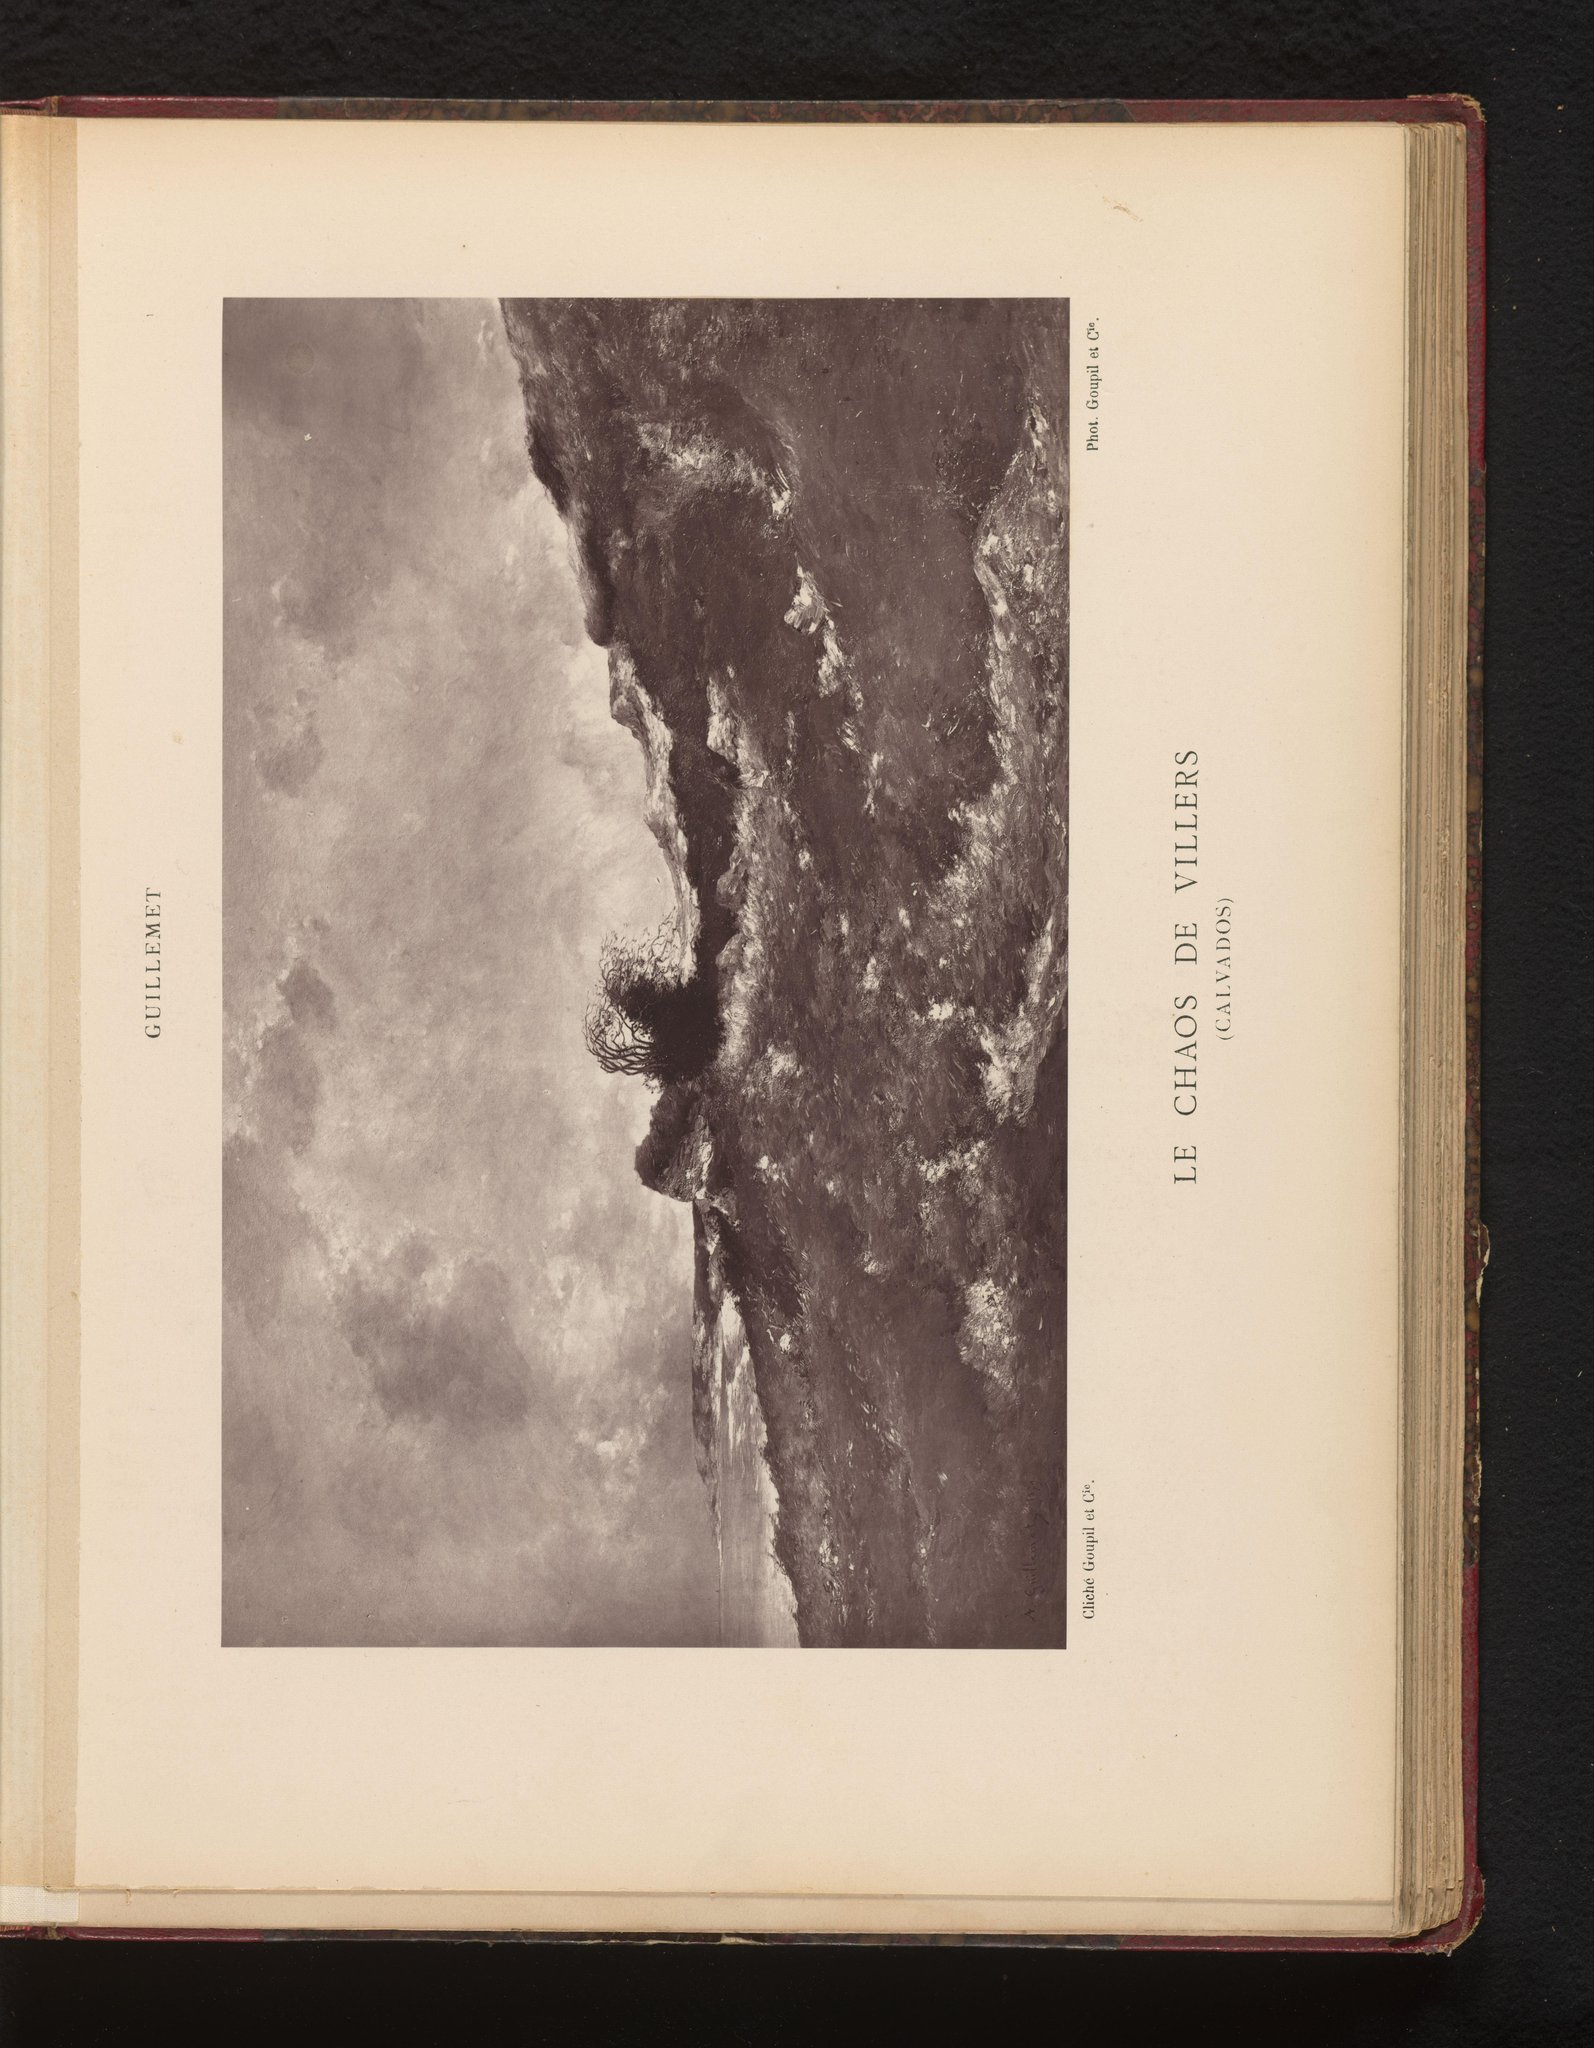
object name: reproduction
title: Fotoreproductie van het schilderij 'Le chaos de Villers (Calvados)' door Antoine Guillemet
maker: jean-baptiste-antoine guillemet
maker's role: painter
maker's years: 1843-1918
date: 1879-1881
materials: paper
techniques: woodburytype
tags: dune coast